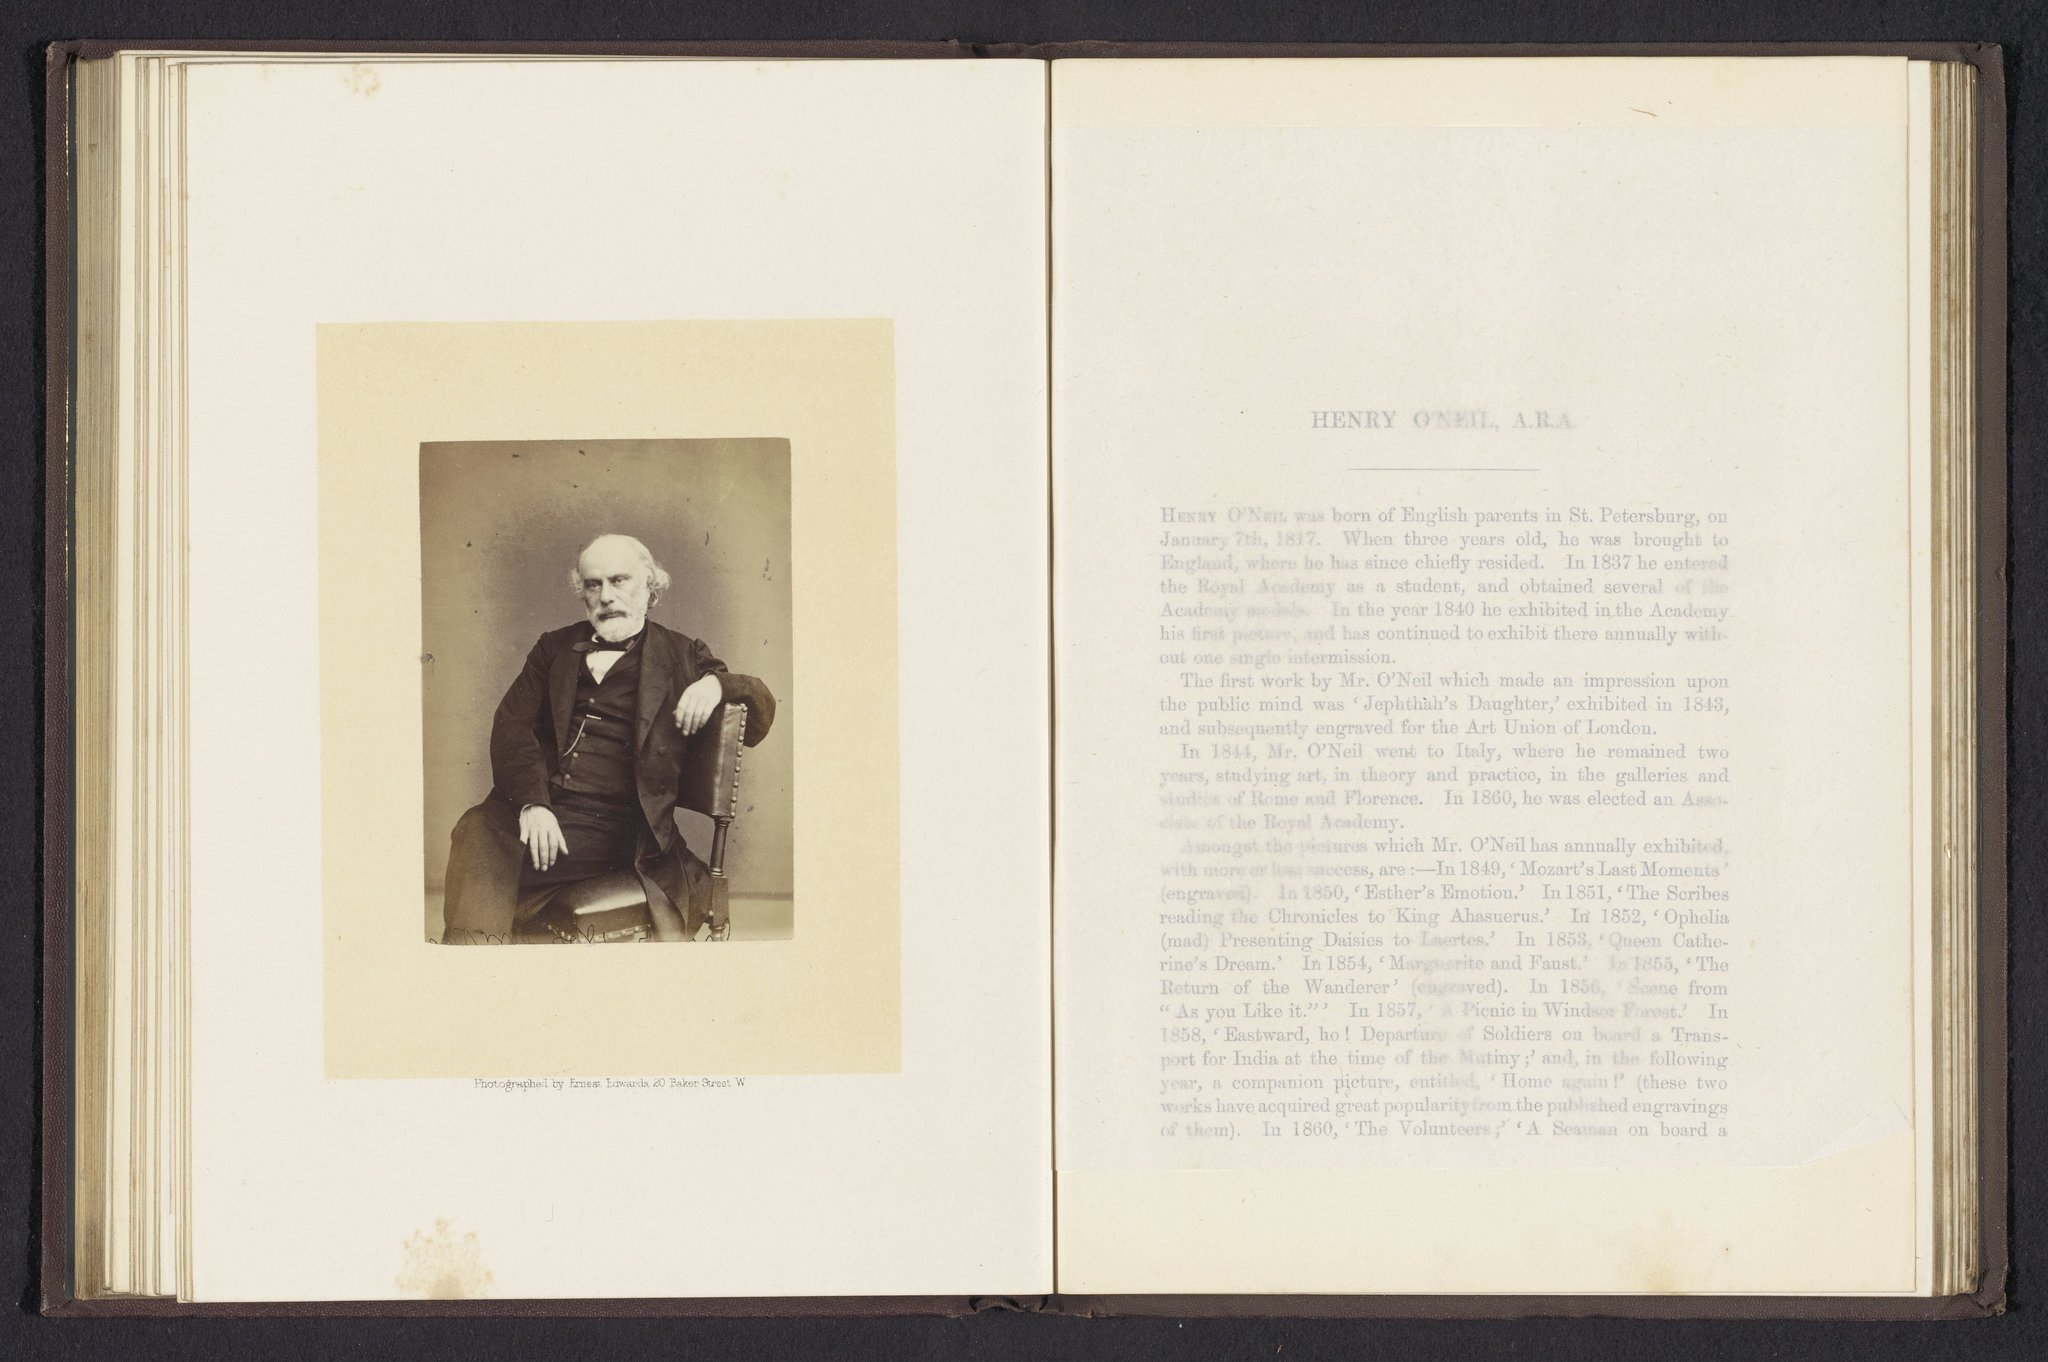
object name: page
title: Portret van Henry Nelson O'Neil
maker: ernest edwards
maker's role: fotograaf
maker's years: 1837-1903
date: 1858-1868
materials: paper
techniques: albumen print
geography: london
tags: historical persons, portrait, self-portrait of painter